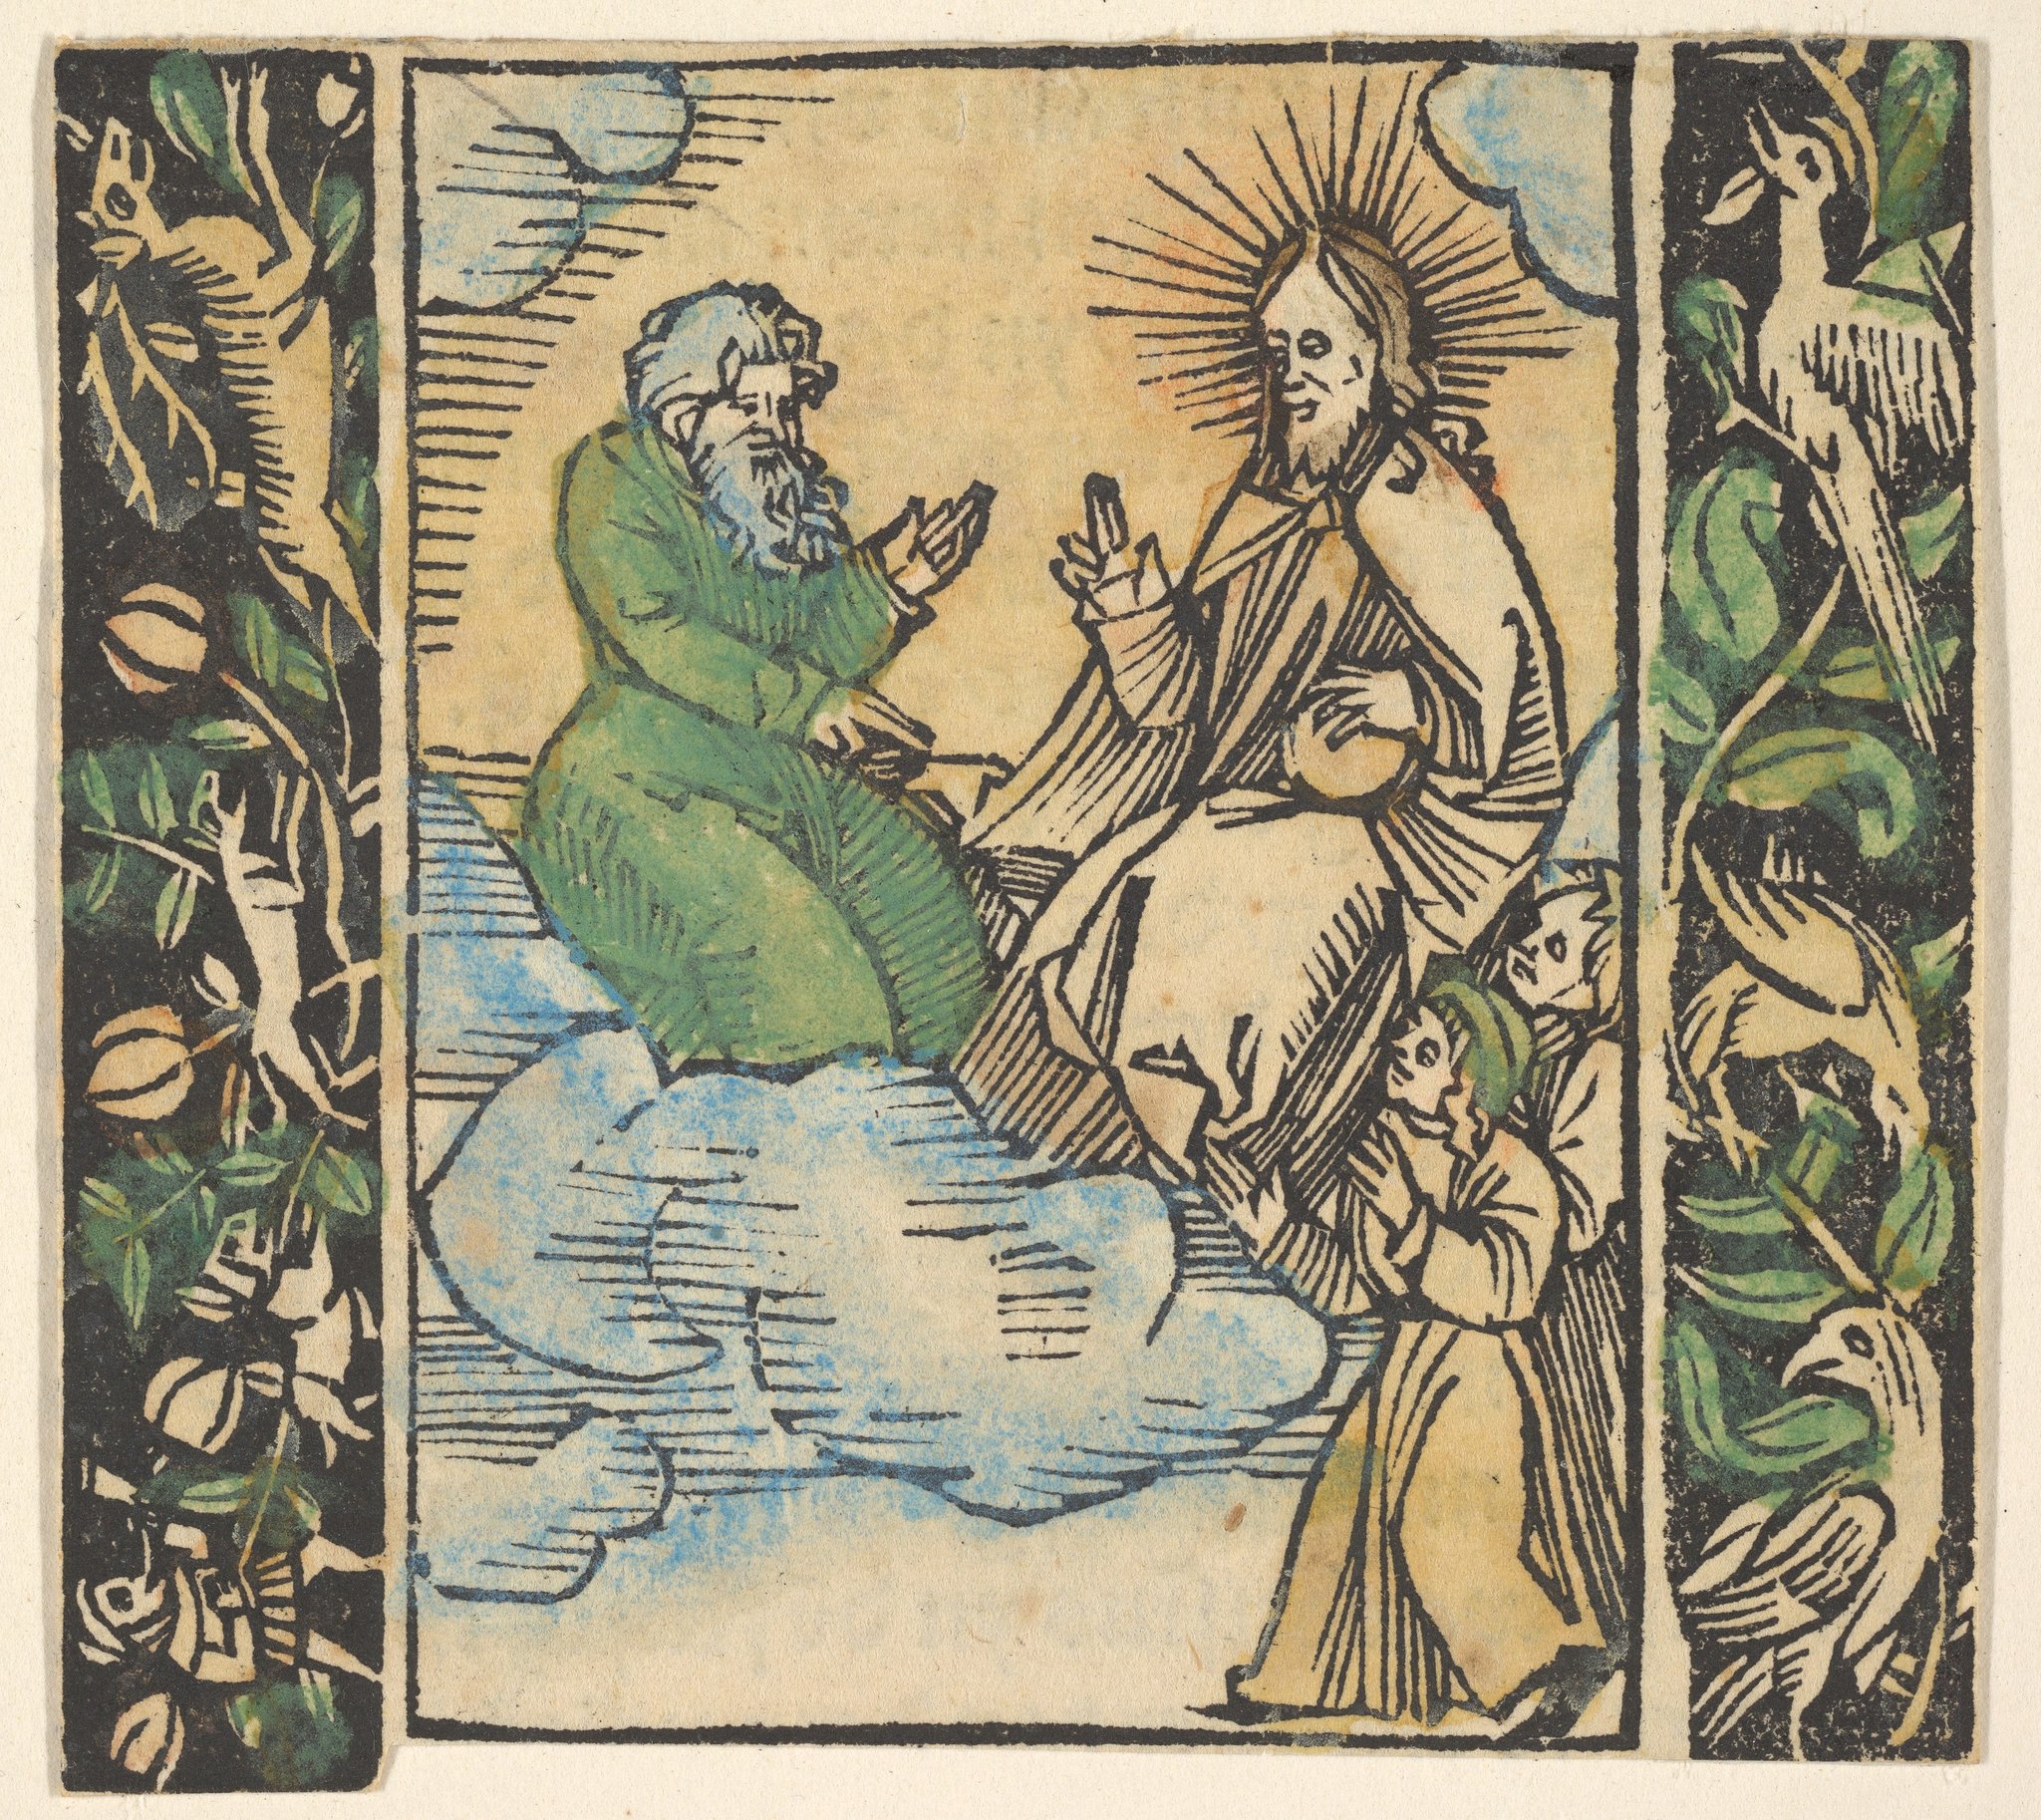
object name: print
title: Illustration from Beschlossen Gart des Rosenkranz Mariae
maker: hans baldung (called hans baldung grien)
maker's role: artist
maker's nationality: german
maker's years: 1484-1545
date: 1500-1545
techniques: hand coloring, woodcut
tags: animals,girls,men,christ